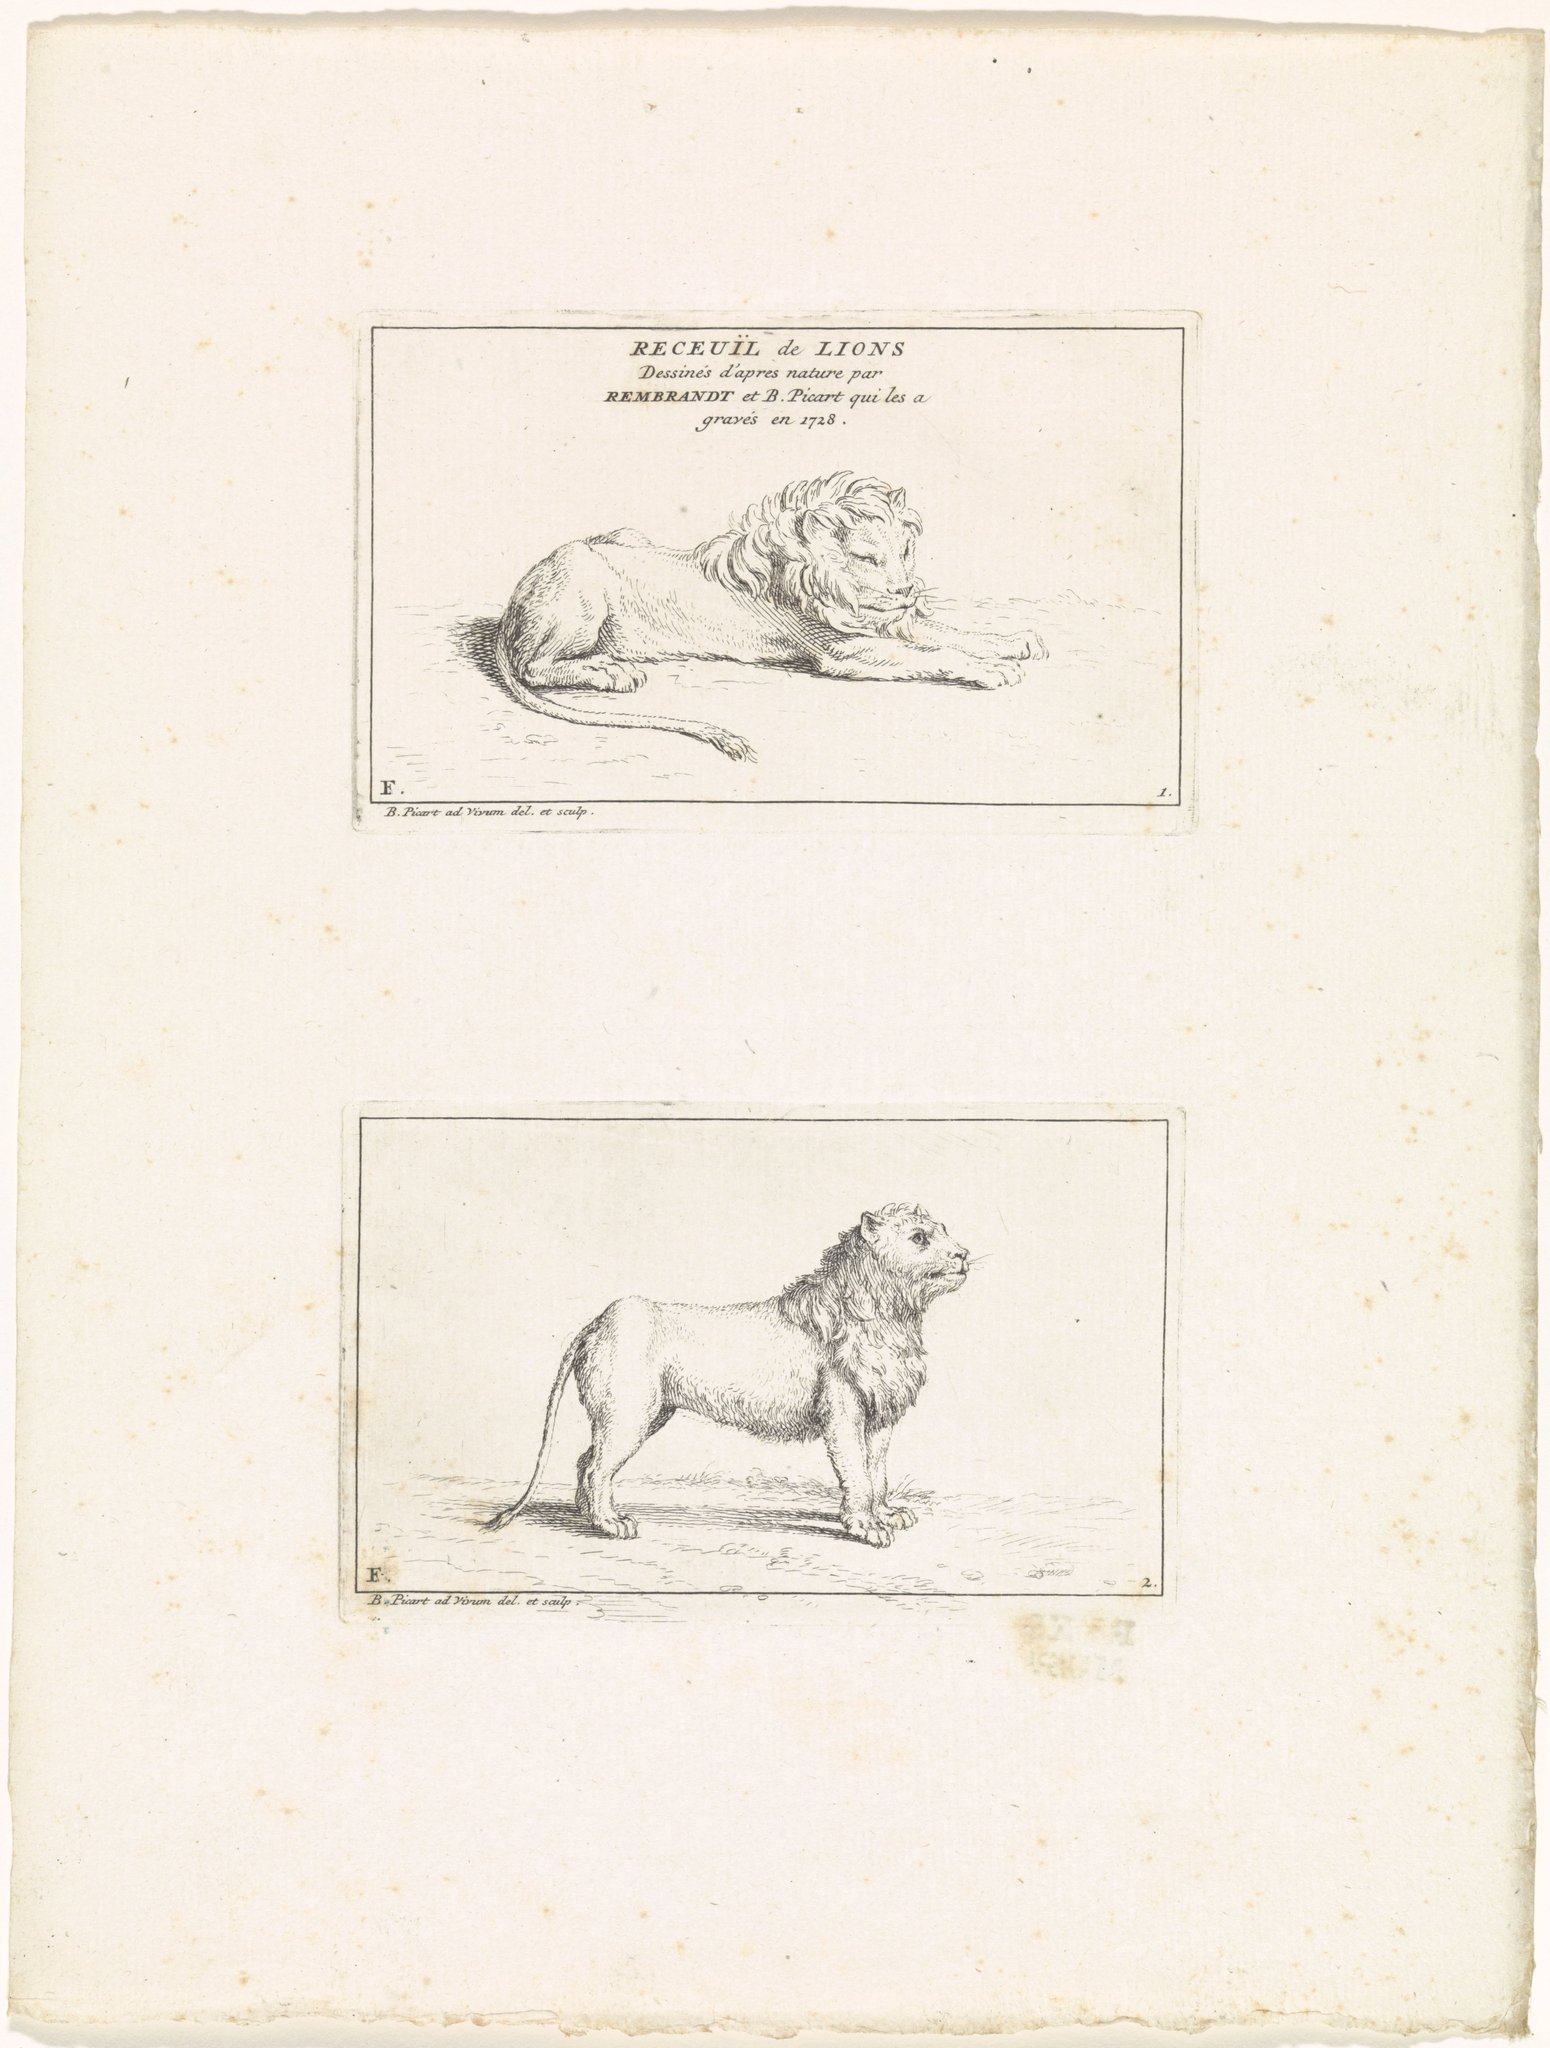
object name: titelprent, frontispice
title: Leeuwen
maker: bernard picart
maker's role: draughtsman, print maker, publisher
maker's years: 1673-1733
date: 1728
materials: paper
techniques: engraving, etching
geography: amsterdam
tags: beasts of prey, predatory animals: lion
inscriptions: collector's mark: Lugt 2165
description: Twee prenten op één blad. De bovenste prent is een titelprent voor de serie met leeuwen. Boven de leeuw de titel in het Frans. Gemerkt linksonder: F. Genummerd rechtsonder: 1. De onderste prent is gemerkt linksonder: F. Genummerd rechtsonder: 2.